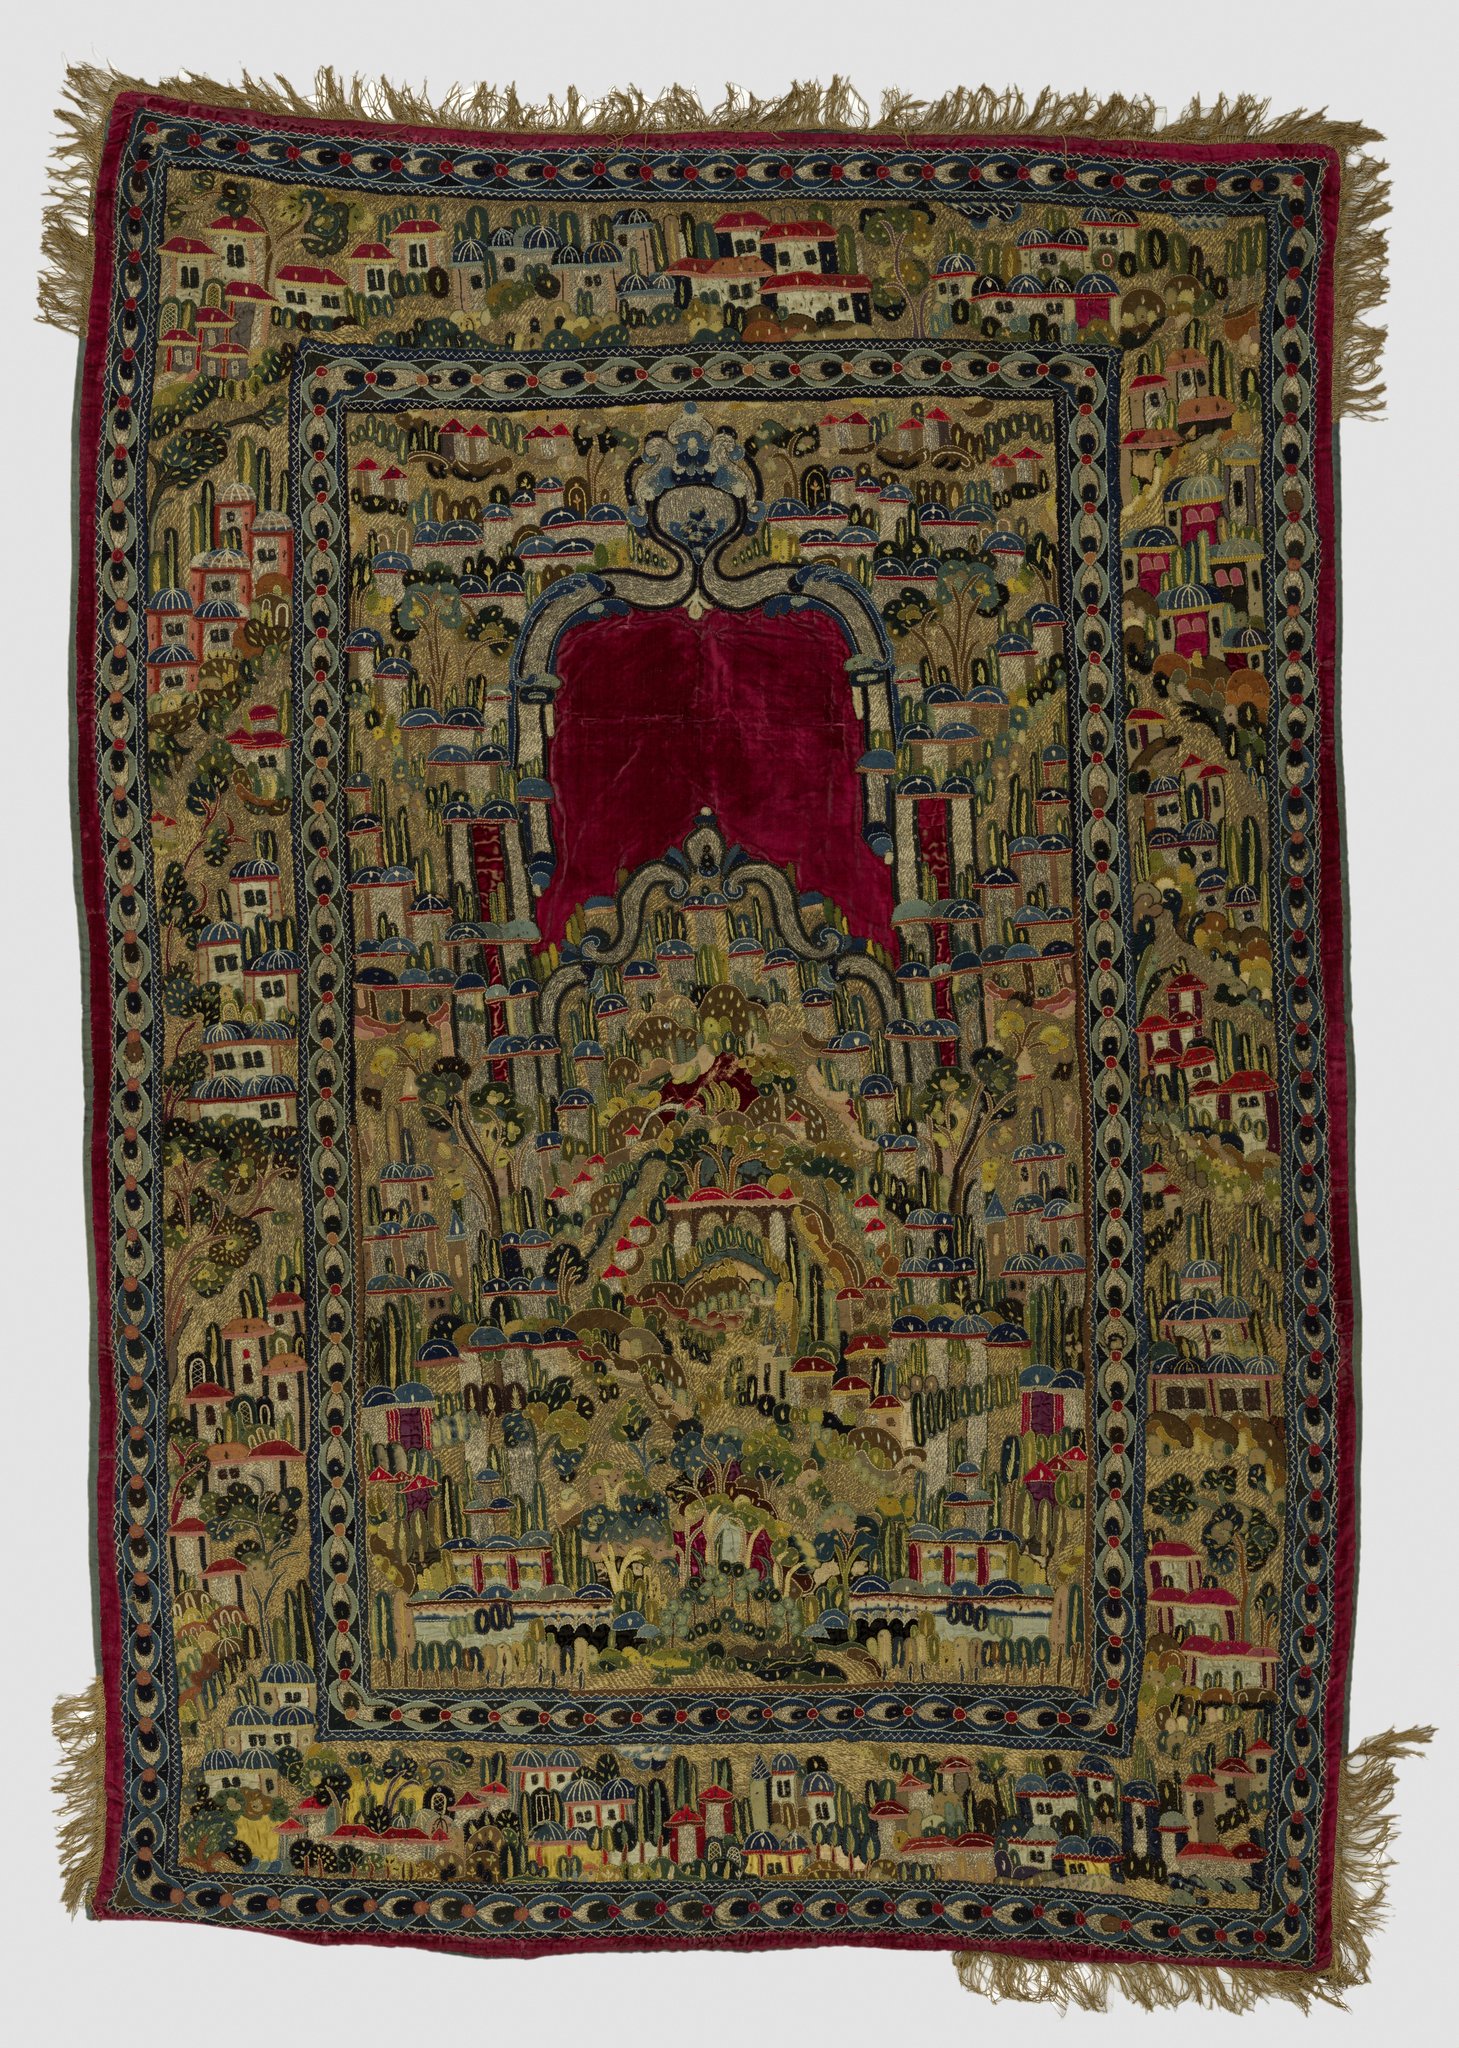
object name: oriental rug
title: Bidkleed (?), veelkleurig geappliqueerd en geborduurd, met op het middenveld een patroon van een heuvellandschap met gebouwen met koepels en bomen.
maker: Anonymous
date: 1840-1900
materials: cotton, gold thread, silk, thread, wool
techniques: embroidered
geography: southeast russia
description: Bidkleed (?) van naturelkleurige katoen (?) met appliqueer- en borduurwerk in diverse kleuren, rondom afgezet met goudgele franje - met lacunes - en gevoerd met blauwe katoen. De centrale voorstelling is gevat in een brede rand met aan weerszijden een smalle rand met een patroon van geschakelde ellipsen. De voorstelling op het middenveld omvat een heuvellandschap gestoffeerd met gebouwen met koepels en bomen. Langs beide hellingen van de heuvel en het centrum gebouwen met koepels die paralel geplaatst zijn aan de omhoog rijzende geschulpte boogstelling. Daarboven een lap rood fluweel, die gevat is in een voortzetting van de geschulpte boogstelling die aan de bovenzijde een uitstulping heeft. De brede randen zijn versierd met soortgelijke heuvels met gebouwen met koepels en bomen. Met uitzondering van de smalle tussenranden is het fond grotendeels bedekt met kleine borduursteken in goud- en zilverdraad.